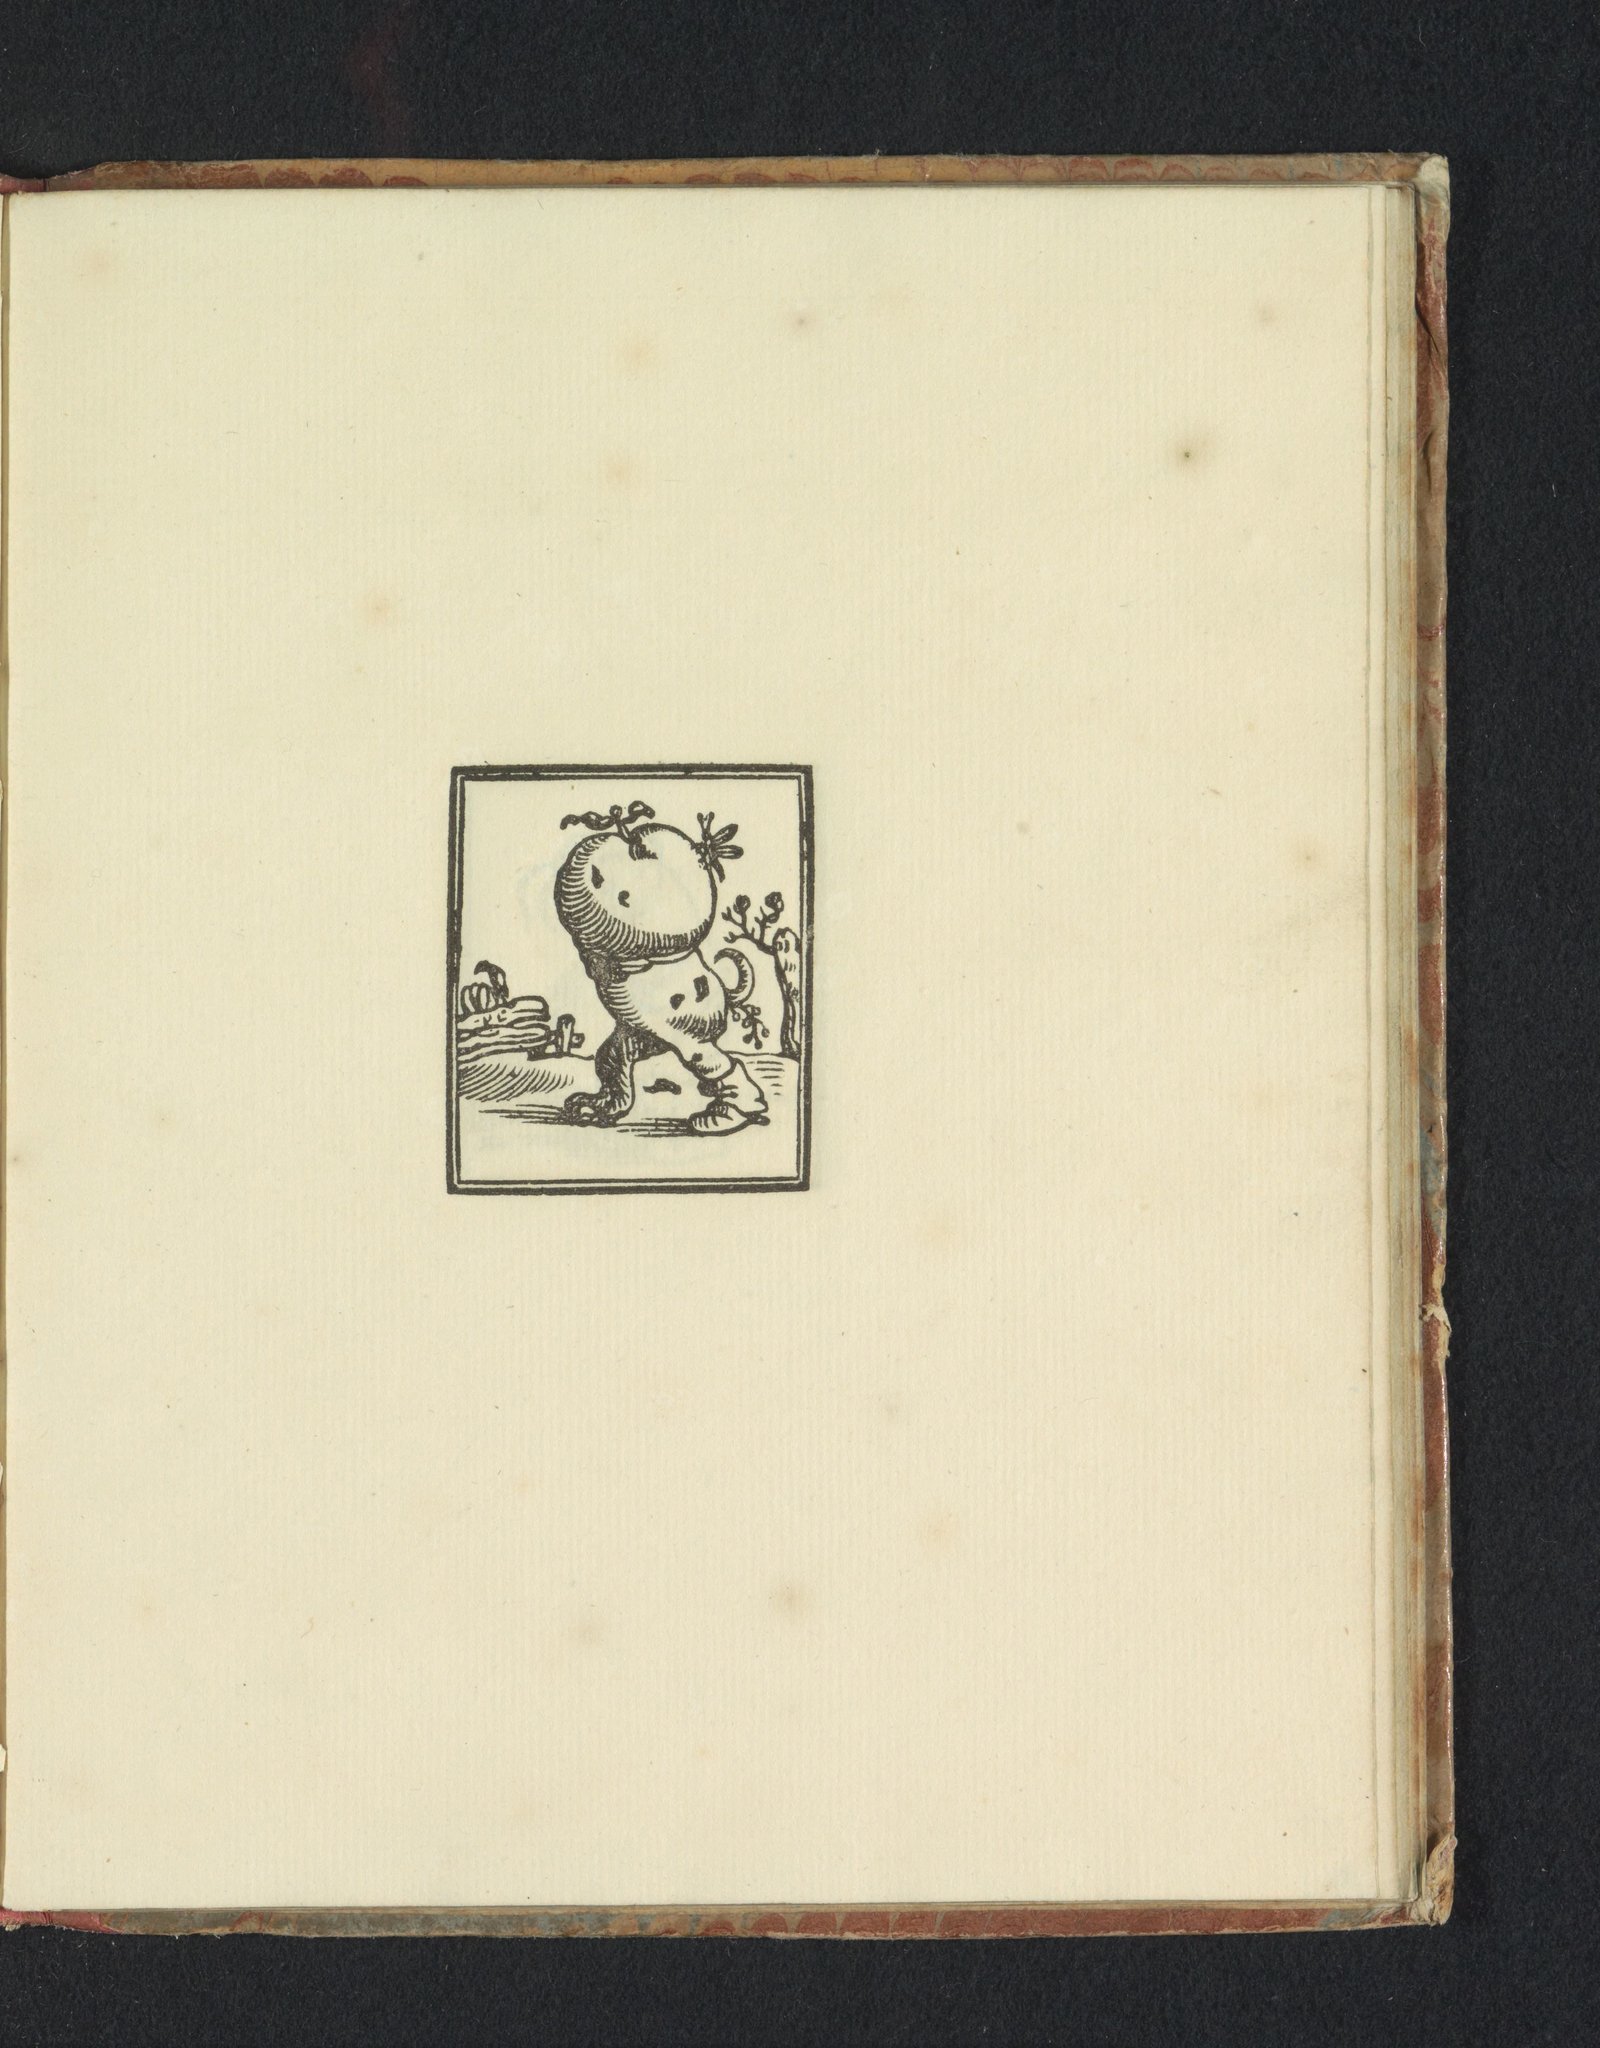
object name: print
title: Appelteef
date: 1731-1732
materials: paper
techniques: woodcut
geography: haarlem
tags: caricatures (human types)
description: Koddige figuur, in het onderschrift in de overzichtsprent draagt deze figuur de naam: Appelteef. Onderdeel van het boekje: XXXVI. aartige figuuren, geinventeert door Izaak van Ostade tot Haarlem [1731-1732].